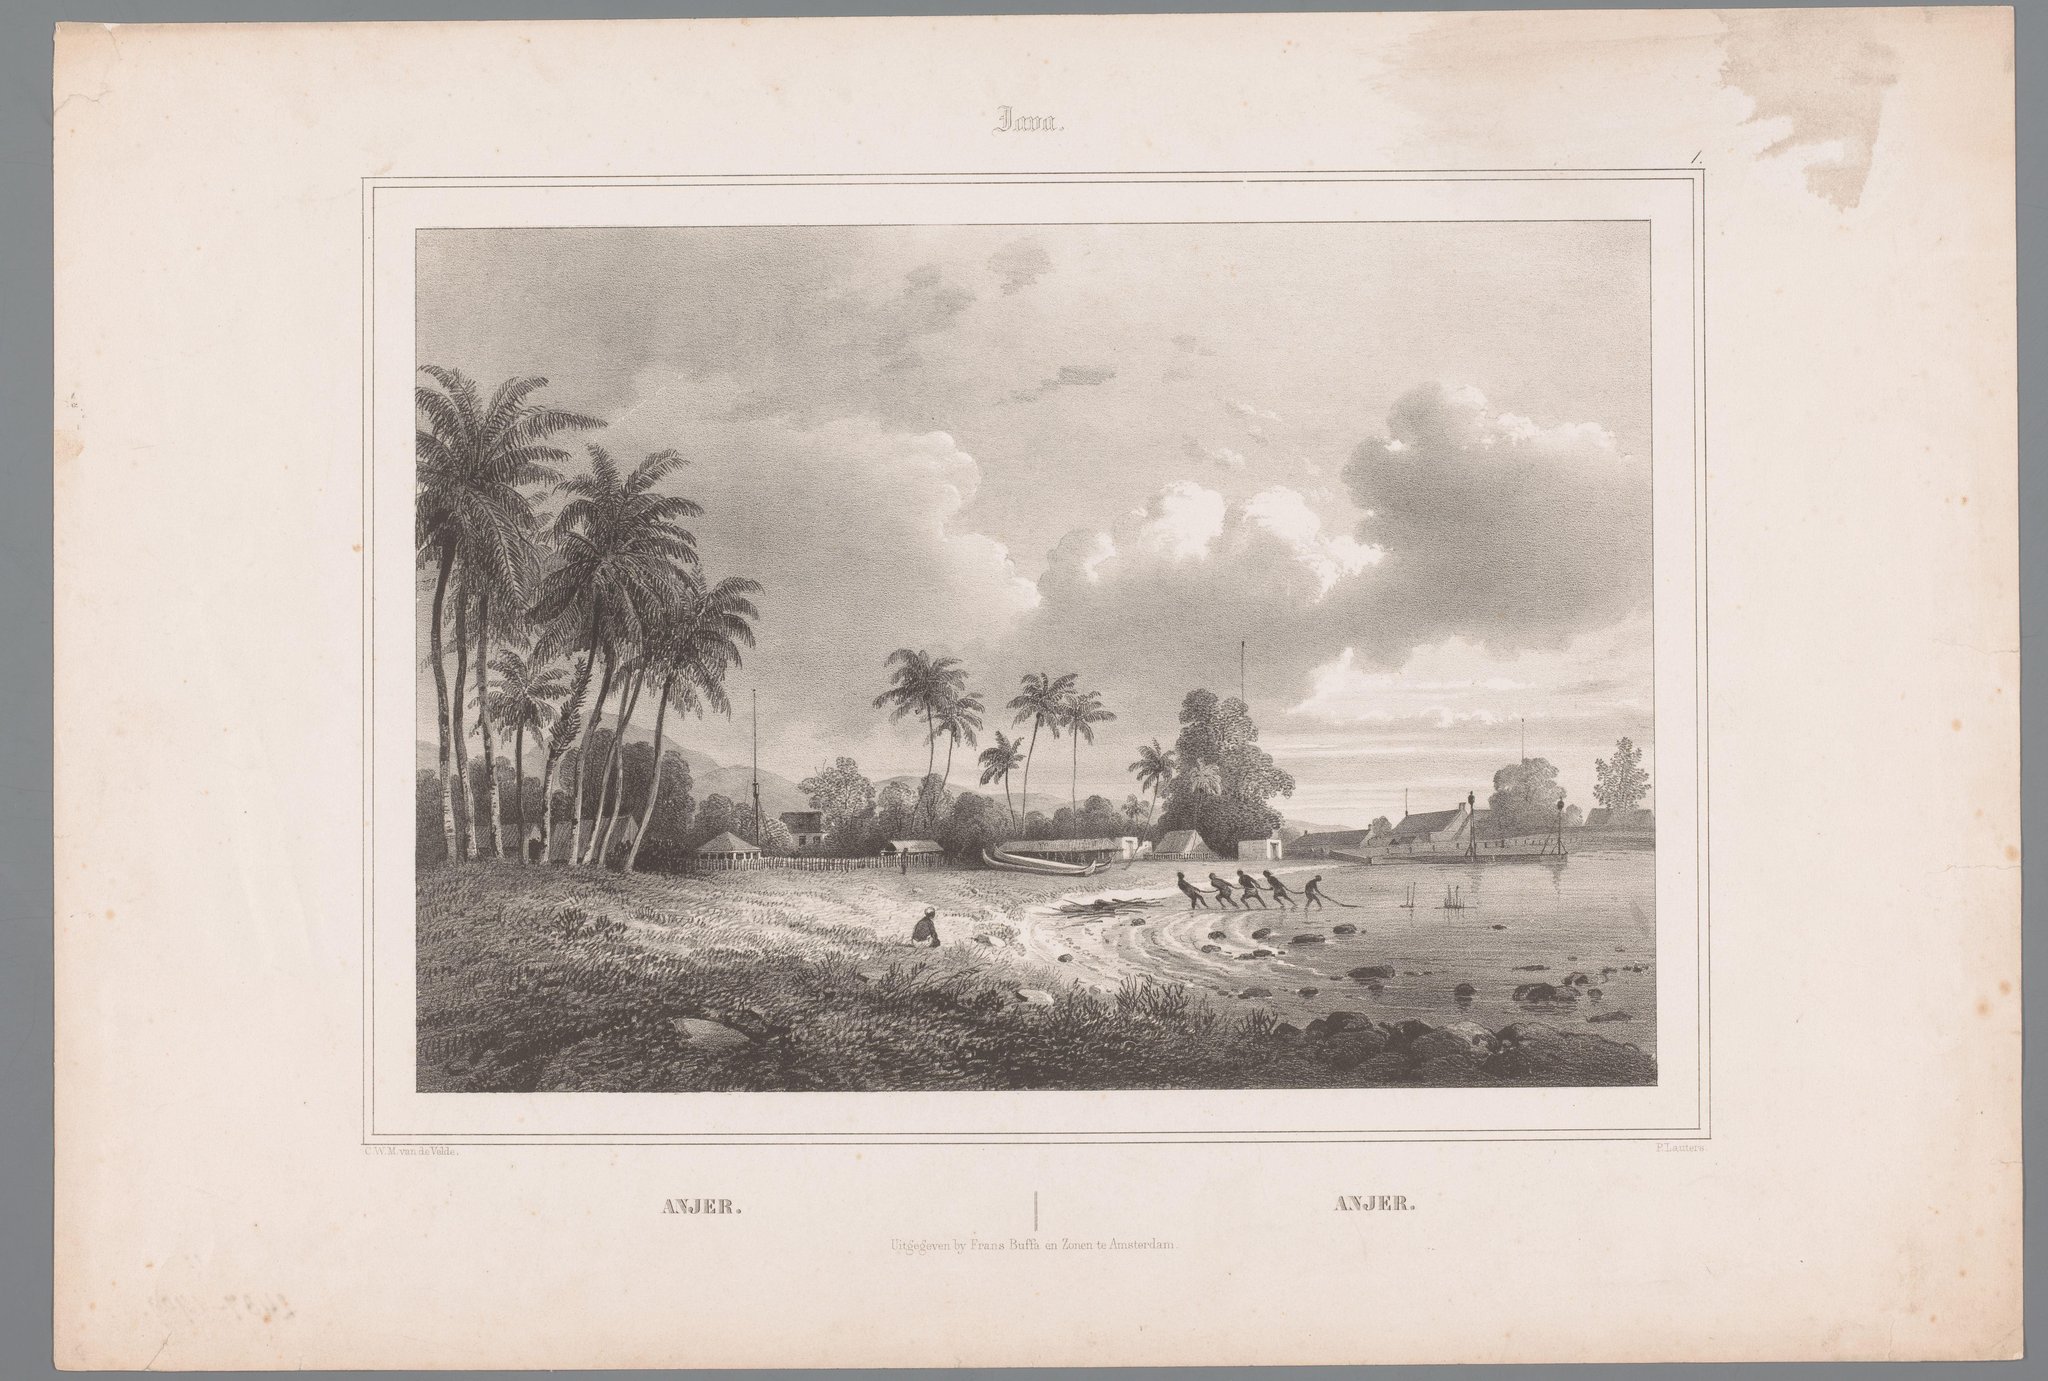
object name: print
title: Java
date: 1847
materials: paper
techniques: lithograph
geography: amsterdam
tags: gulf, bay, city-view in general; 'veduta', fishing net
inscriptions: label: ‘Koloniaal Instituut - Amsterdam; No. 202; Doos No. 3’, collector's mark: Lugt 2228, inscription: ‘13; 2487-1909’, stamp: ‘Koloniaal Museum Haarlem’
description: Andere staat behoort tot de serie: Gezigten uit Neerlands Indië. Amsterdam: Frans Buffa en Zonen, [1847].